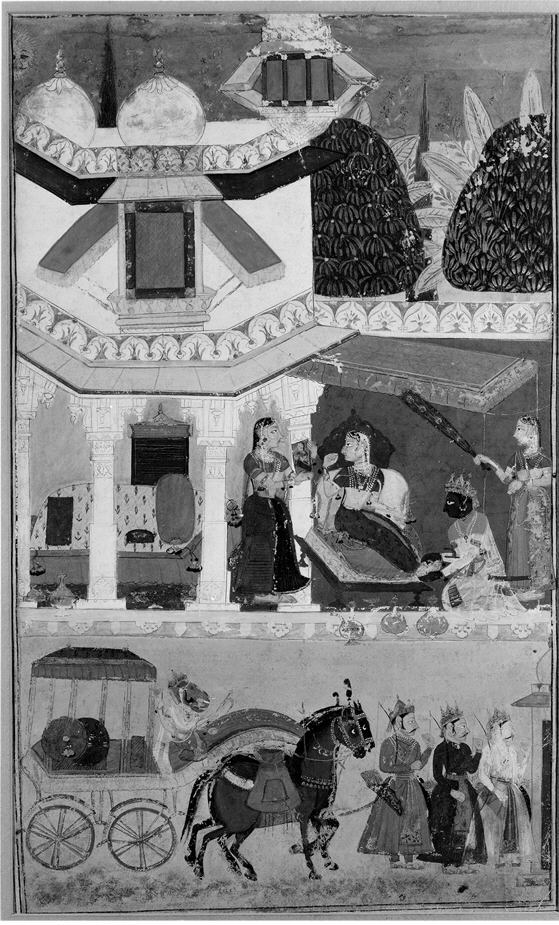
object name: folio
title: Ramkali Ragini: Folio from a ragamala series (Garland of Musical Modes)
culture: mewar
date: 1680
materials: ink, paper, watercolor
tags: women,horses,krishna,radha,hinduism,chariots